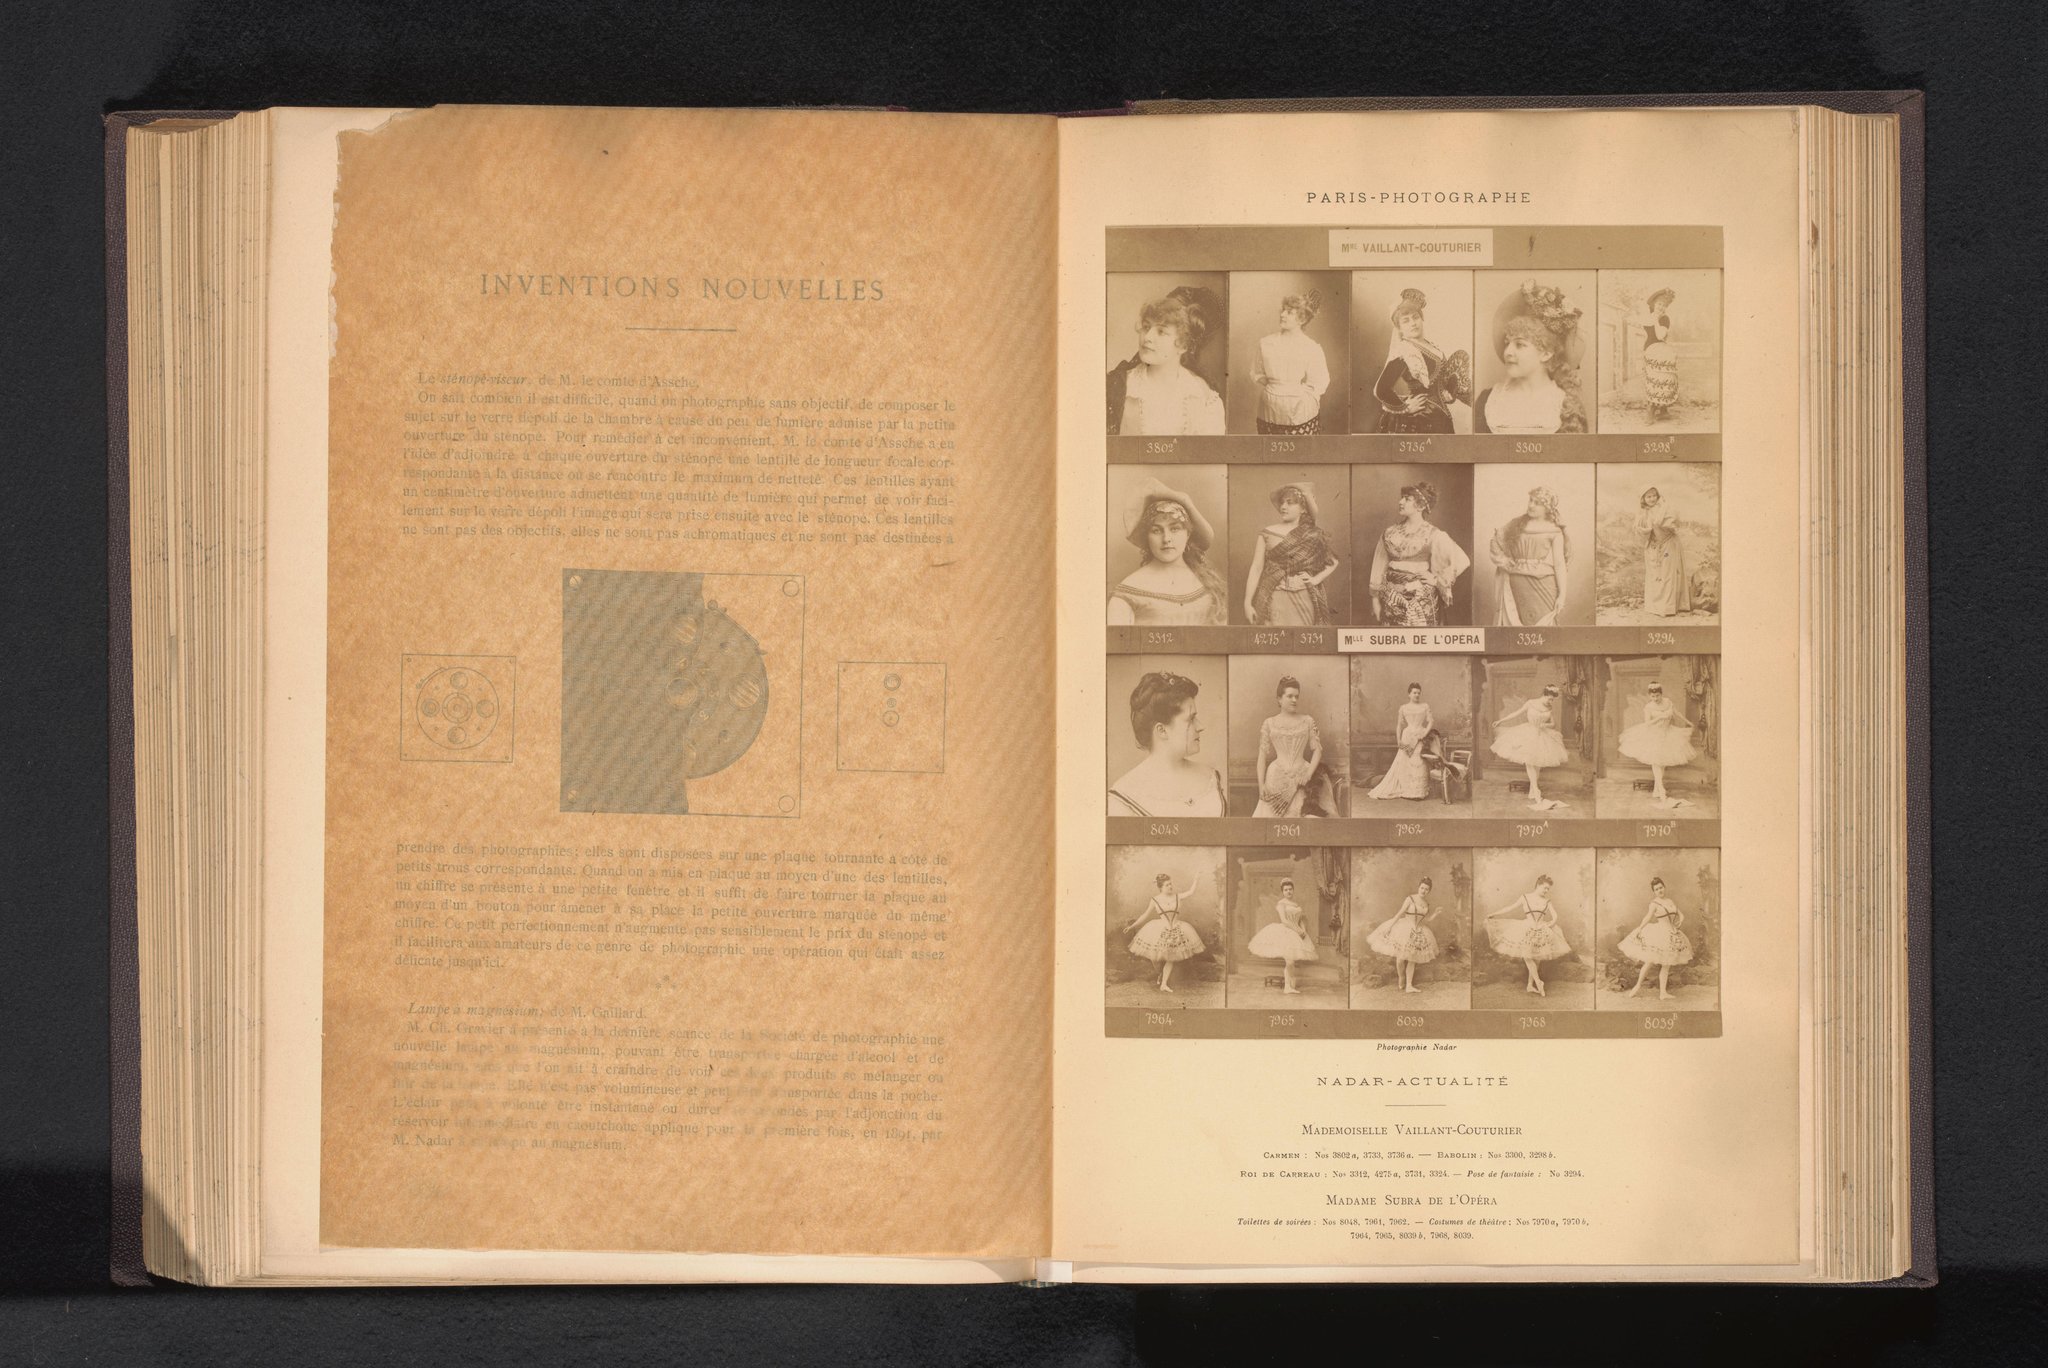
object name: page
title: Twintig portretten van Marguerite Vaillant-Couturier en Julia Subra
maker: félix nadar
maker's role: ballonvaarder, fotograaf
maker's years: 1820-1910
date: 1882-1892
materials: photographic support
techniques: albumen print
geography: paris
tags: stage costume, portrait of opera-singer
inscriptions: number: ‘3802 A (...) 8039B’, inscription: ‘Mademoiselle Vaillant-Couturier (...) Madame Subra de l'Opéra (...)’